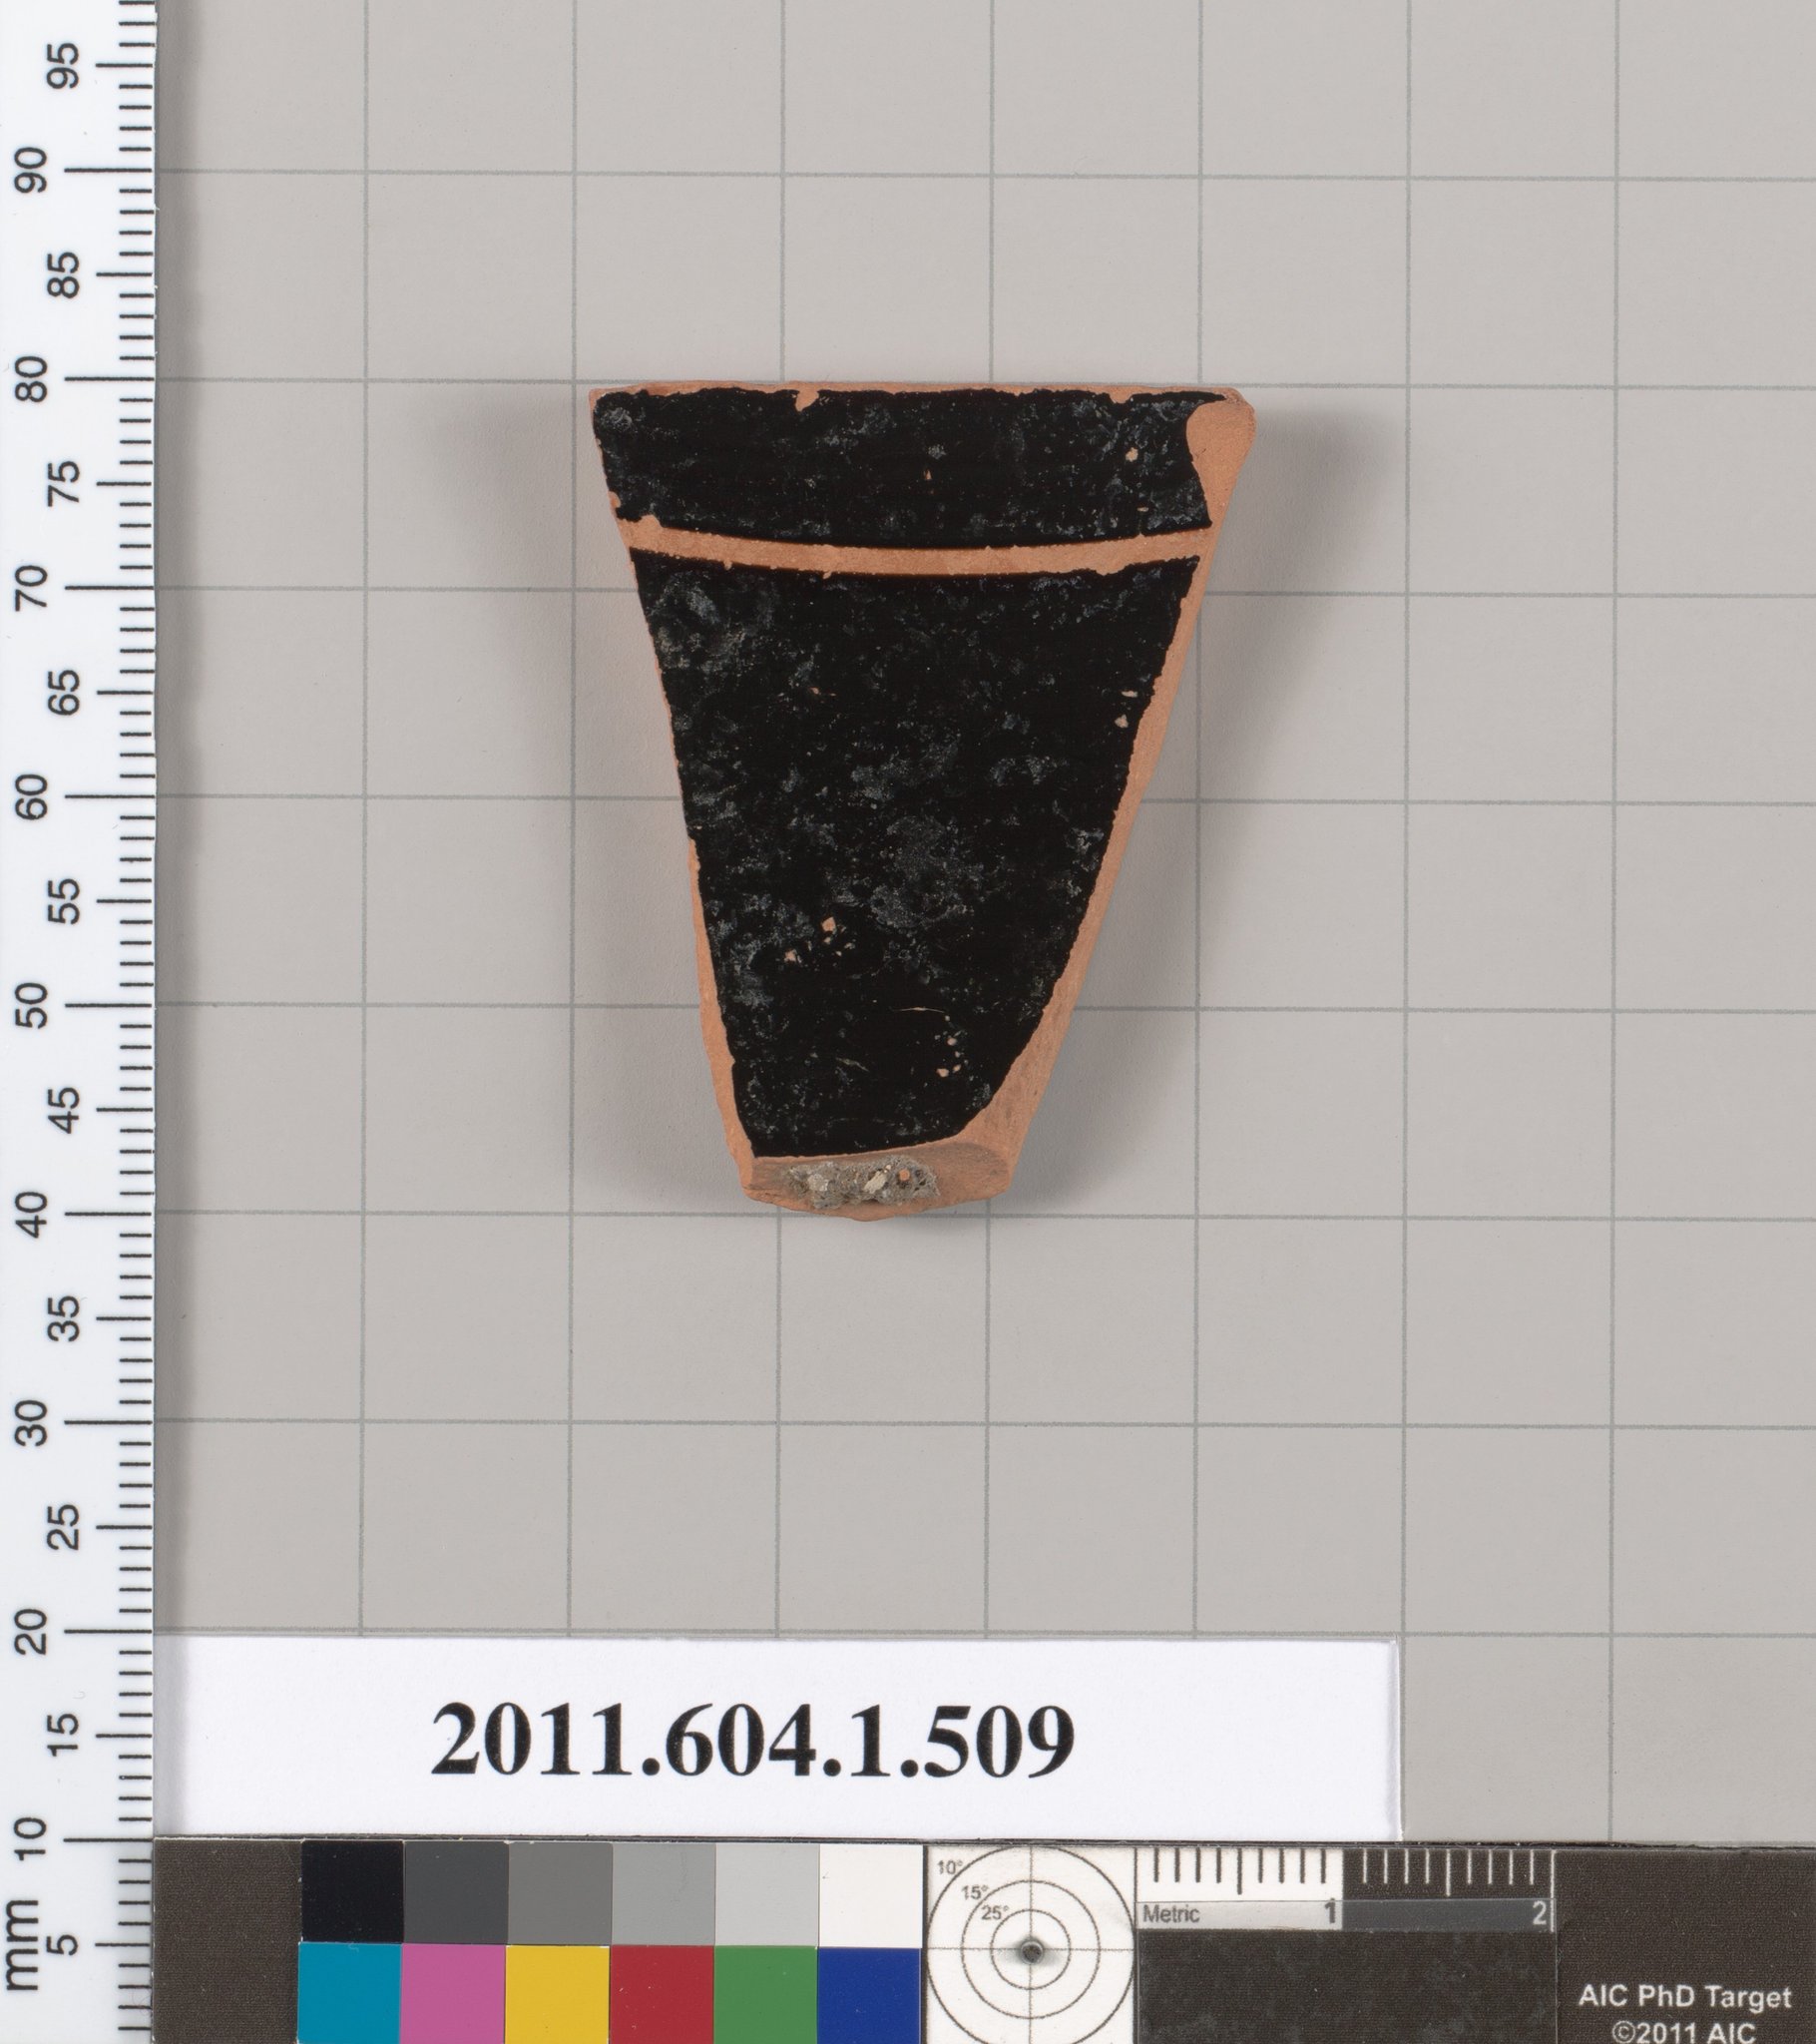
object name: kylix fragment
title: Terracotta fragment of a kylix (drinking cup)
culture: greek, attic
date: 500-476 BCE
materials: terracotta